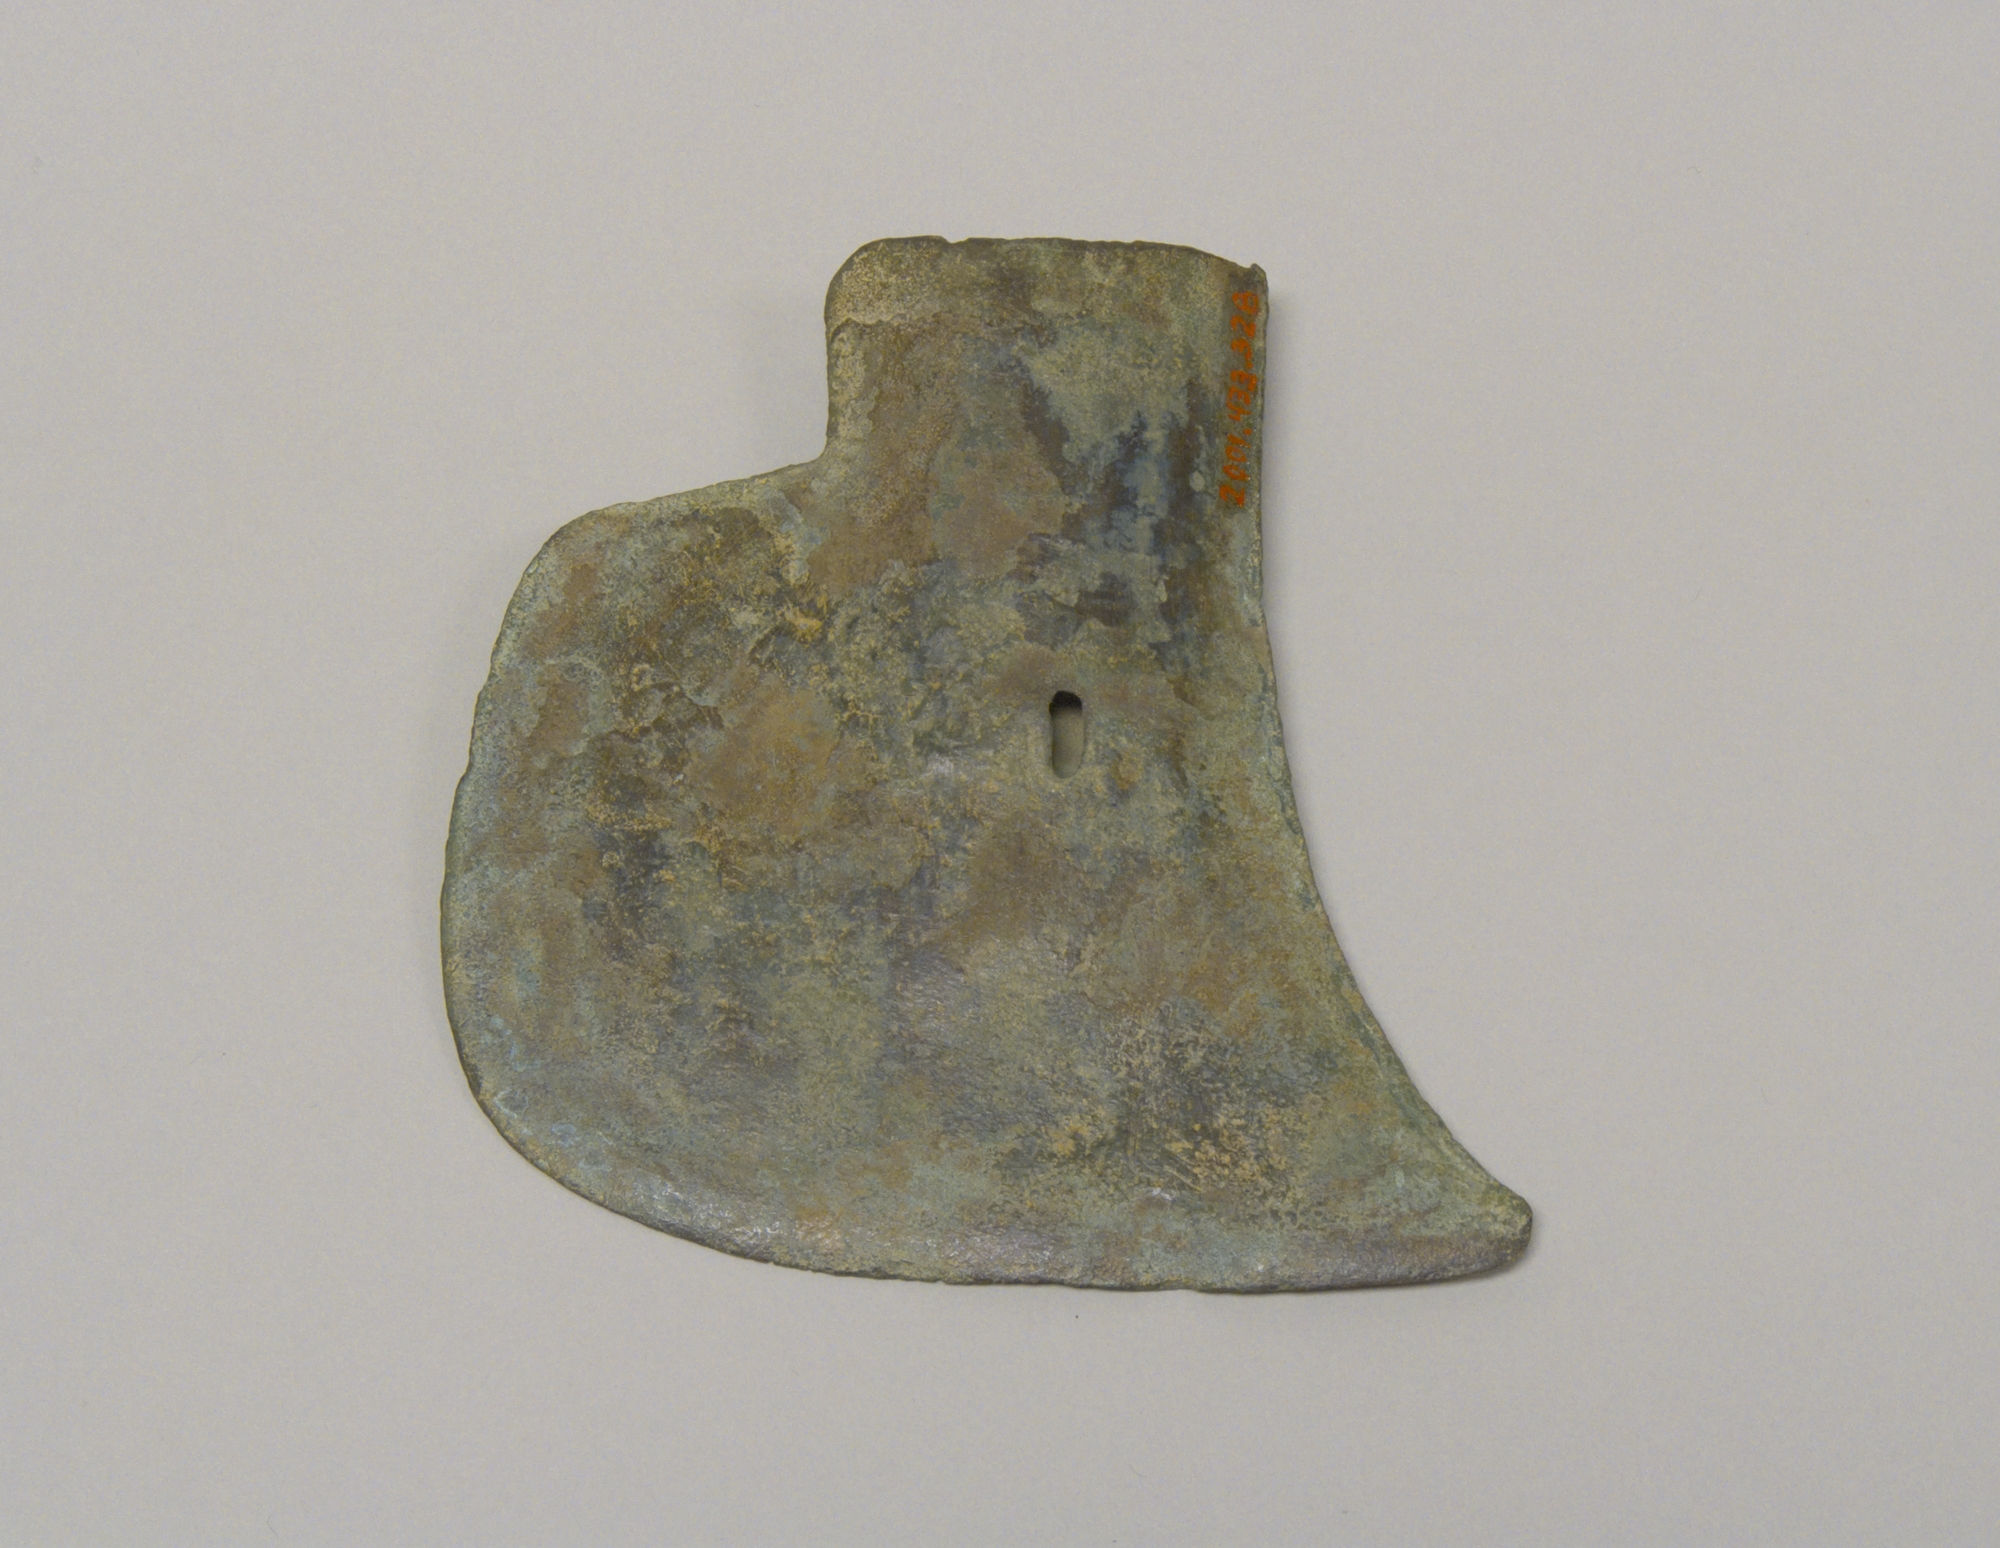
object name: hafted ax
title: Boot-Shaped Hafted Ax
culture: vietnamese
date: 500 BCE-300 CE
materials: bronze